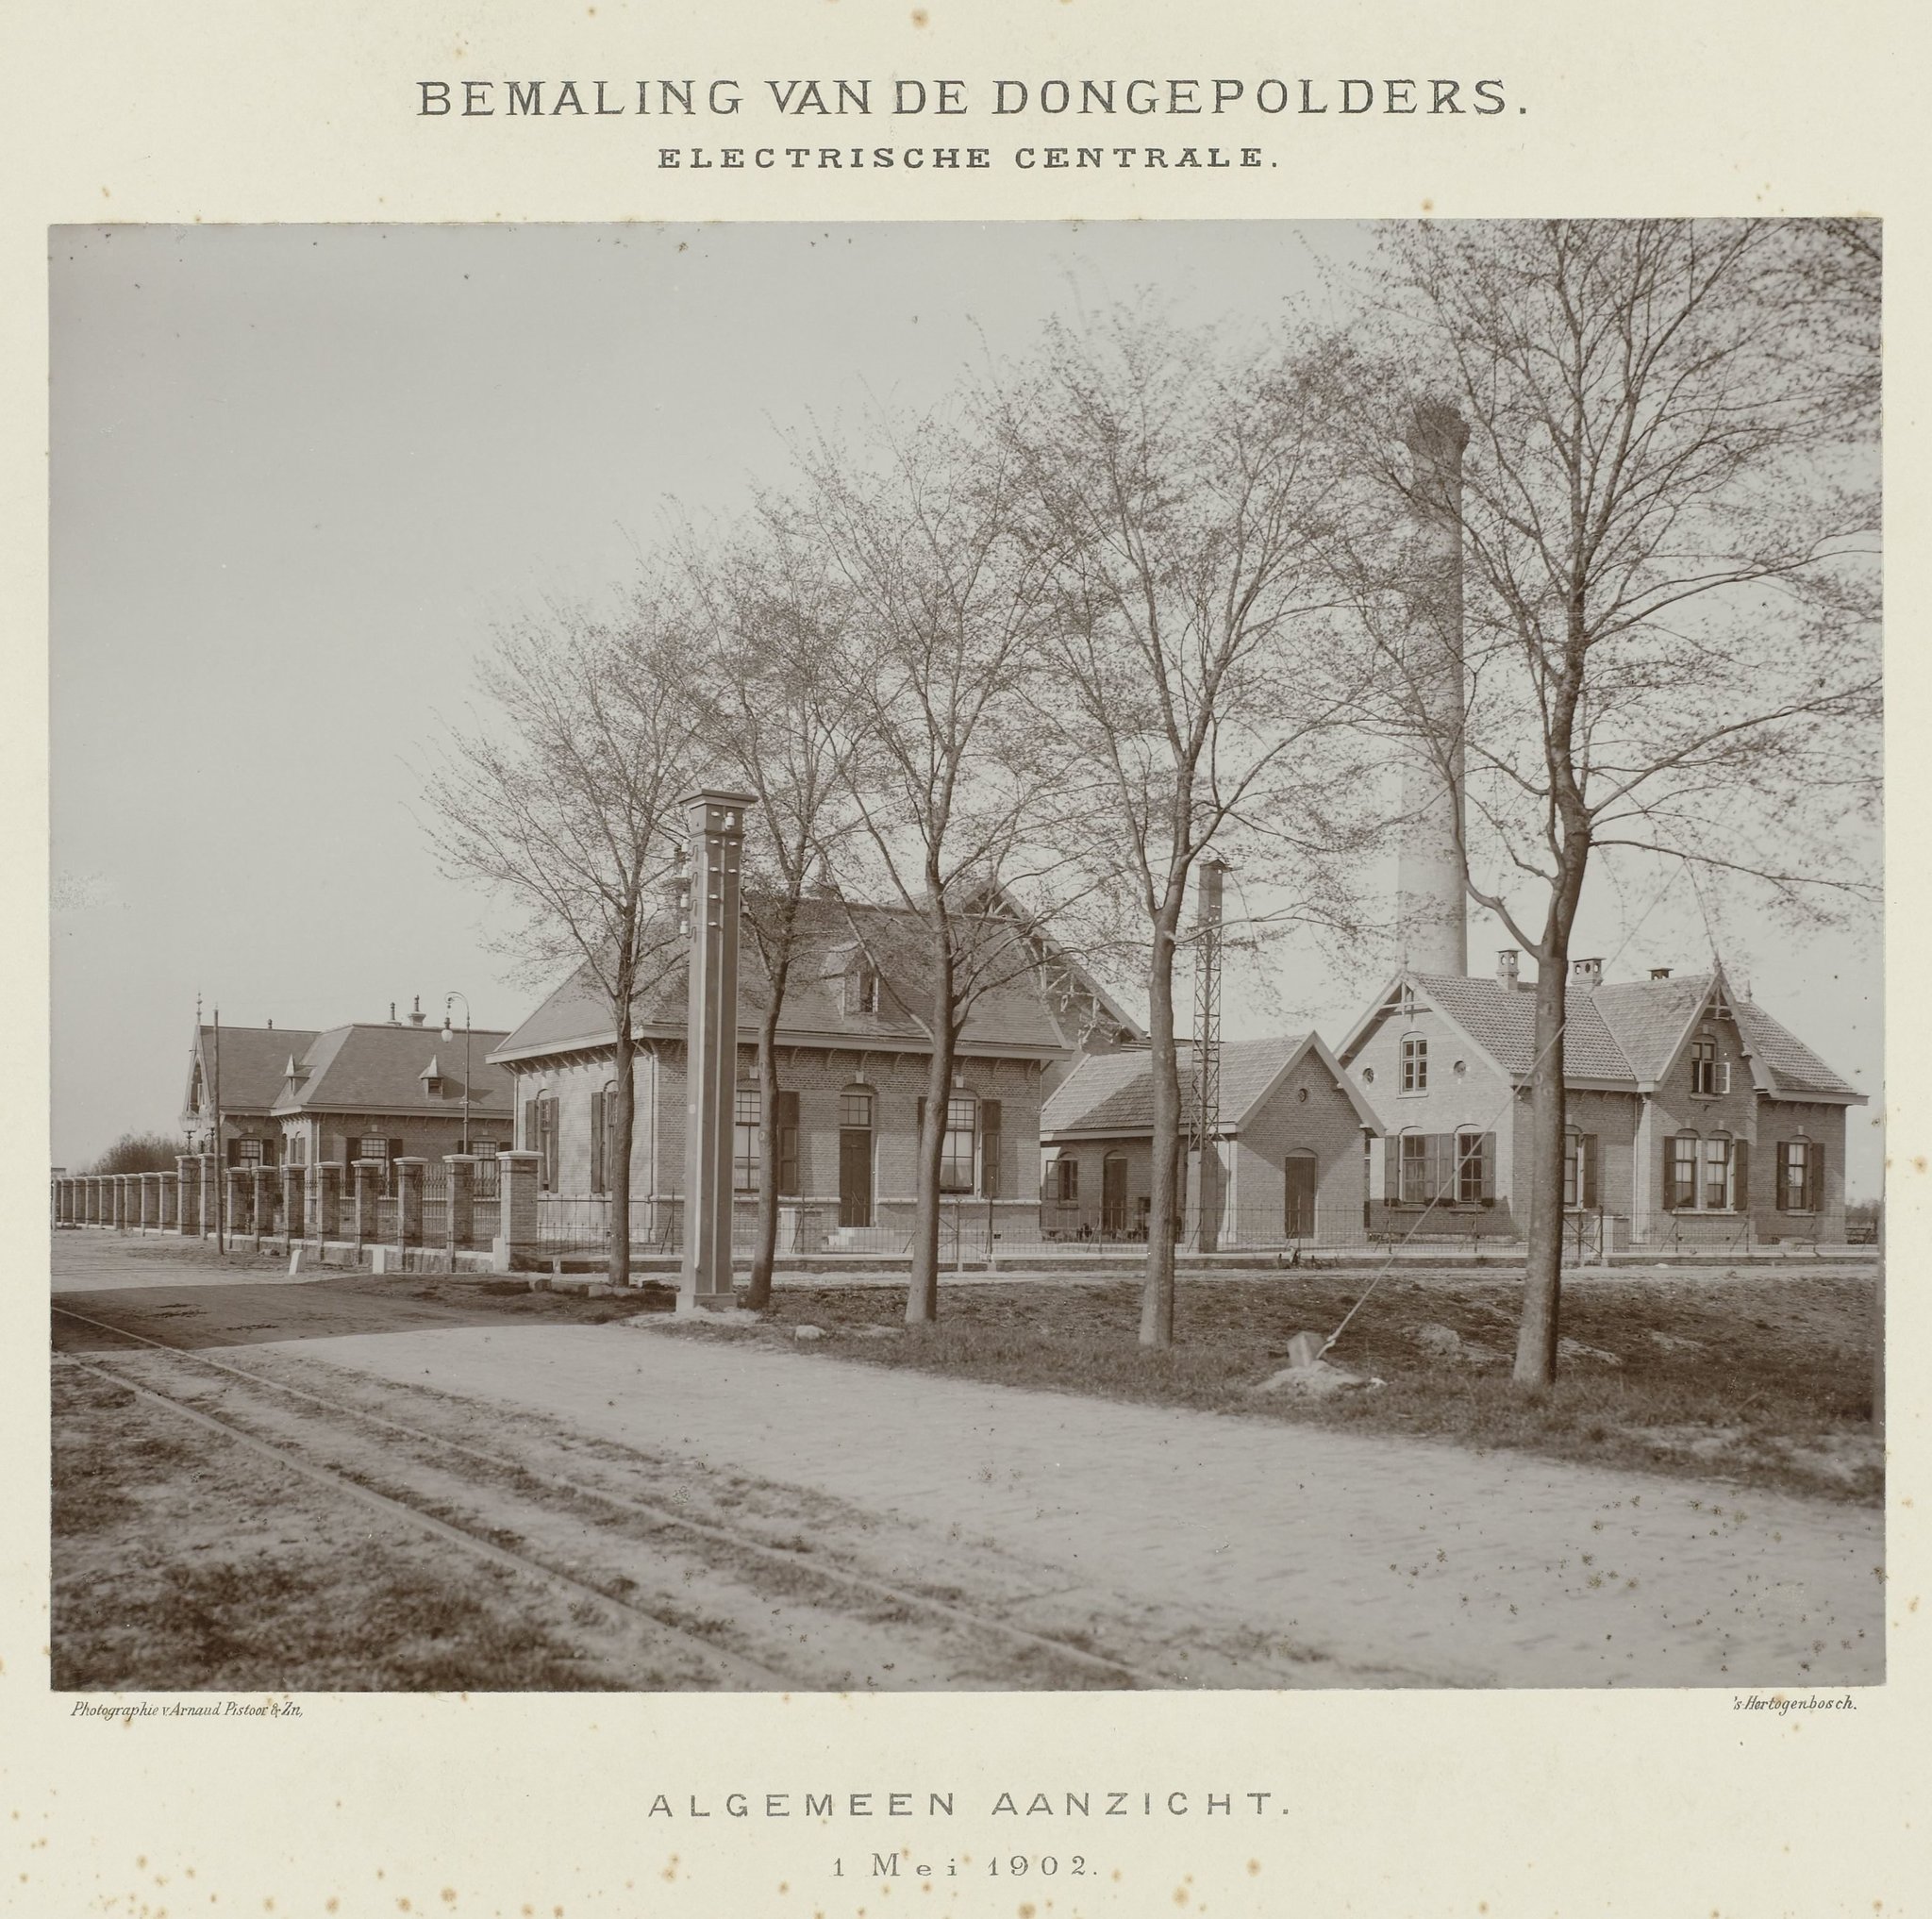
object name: photograph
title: Bemaling van de Dongepolders. Electrische Centrale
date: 1902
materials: cardboard, paper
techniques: photography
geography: den bosch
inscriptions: date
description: Foto op karton van een electrisch gemaal (van de Donge polders). Opschrift: 'Algemeen aanzicht, 1 mei 1902'. Gedateeerd en gesigneerd.